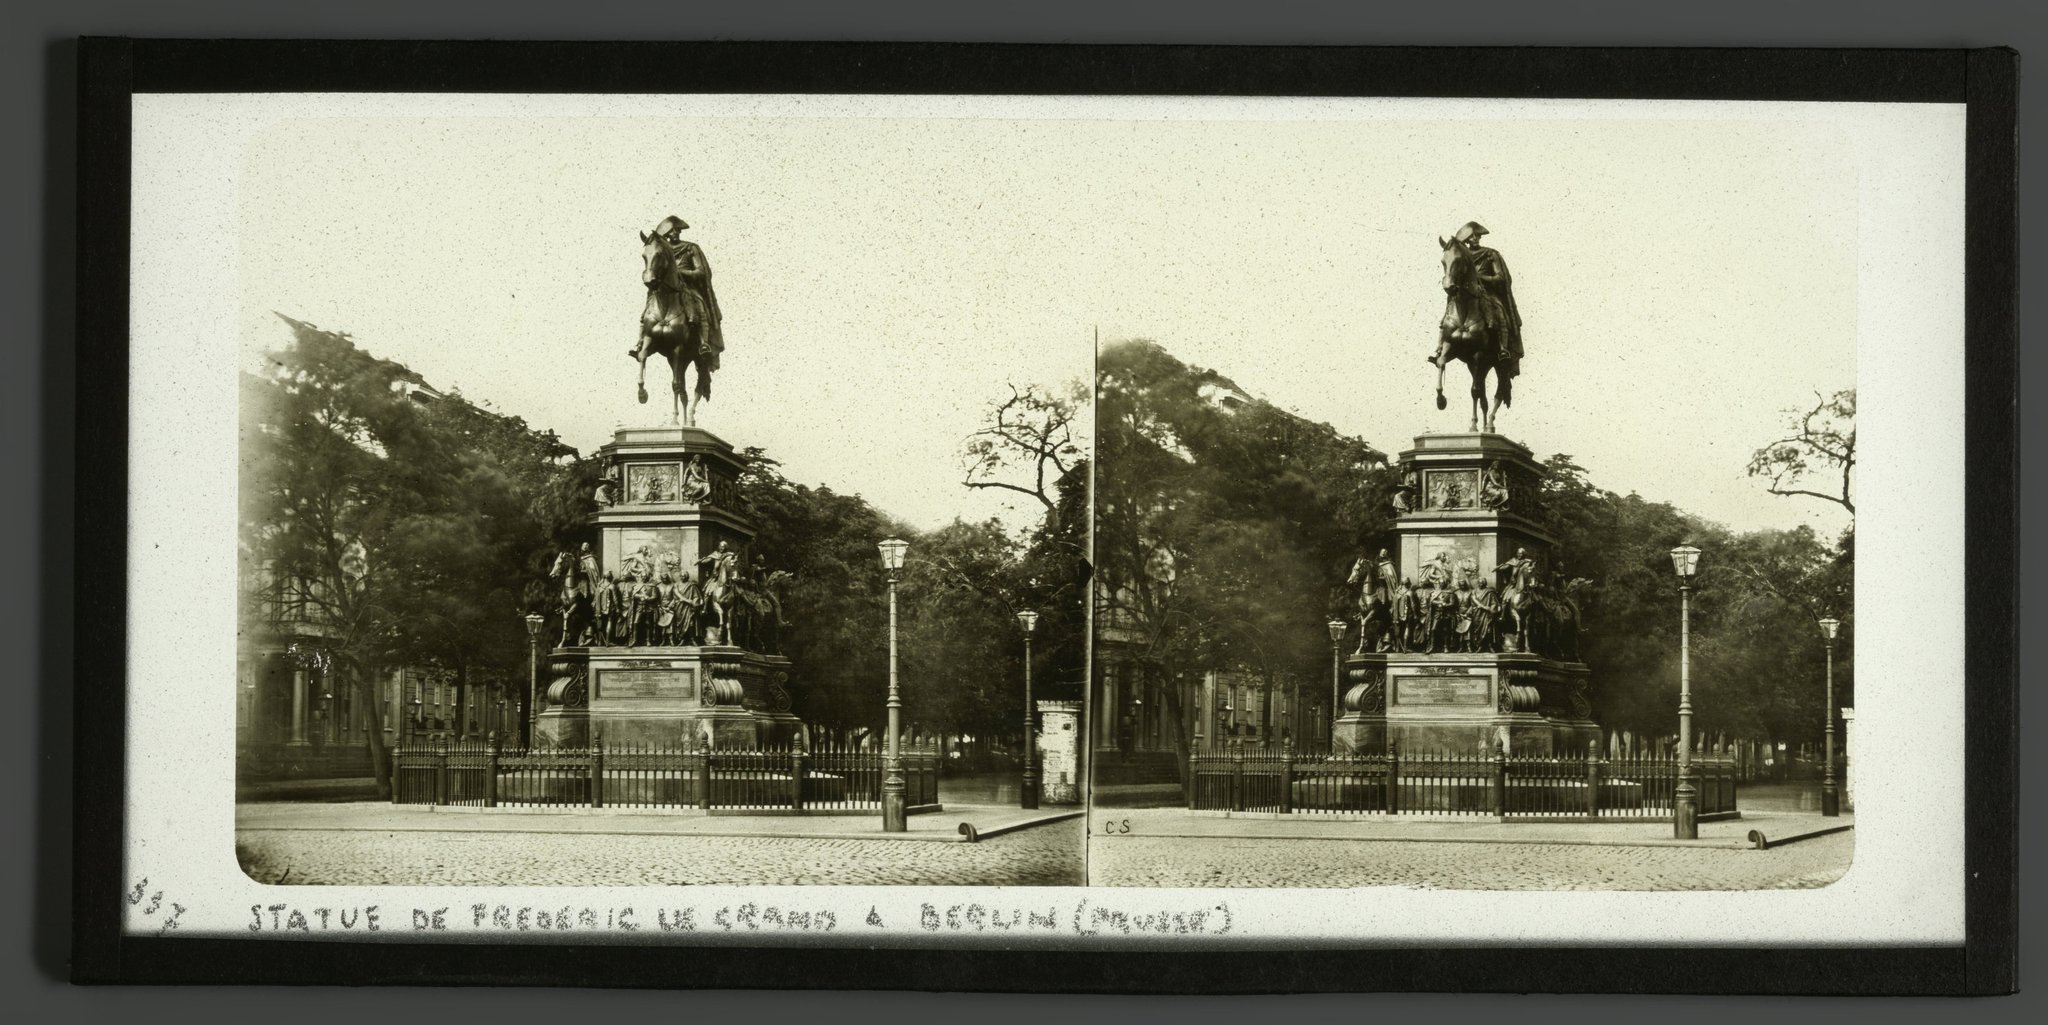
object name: stereoscopic photograph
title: Ruiterstandbeeld van Frederik de Grote in Berlijn, Duitsland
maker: Anonymous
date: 1860-1890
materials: glass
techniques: slide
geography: berlin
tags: berlin, frederick ii (king of prussia), equestrian statue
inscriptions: number: ‘537’